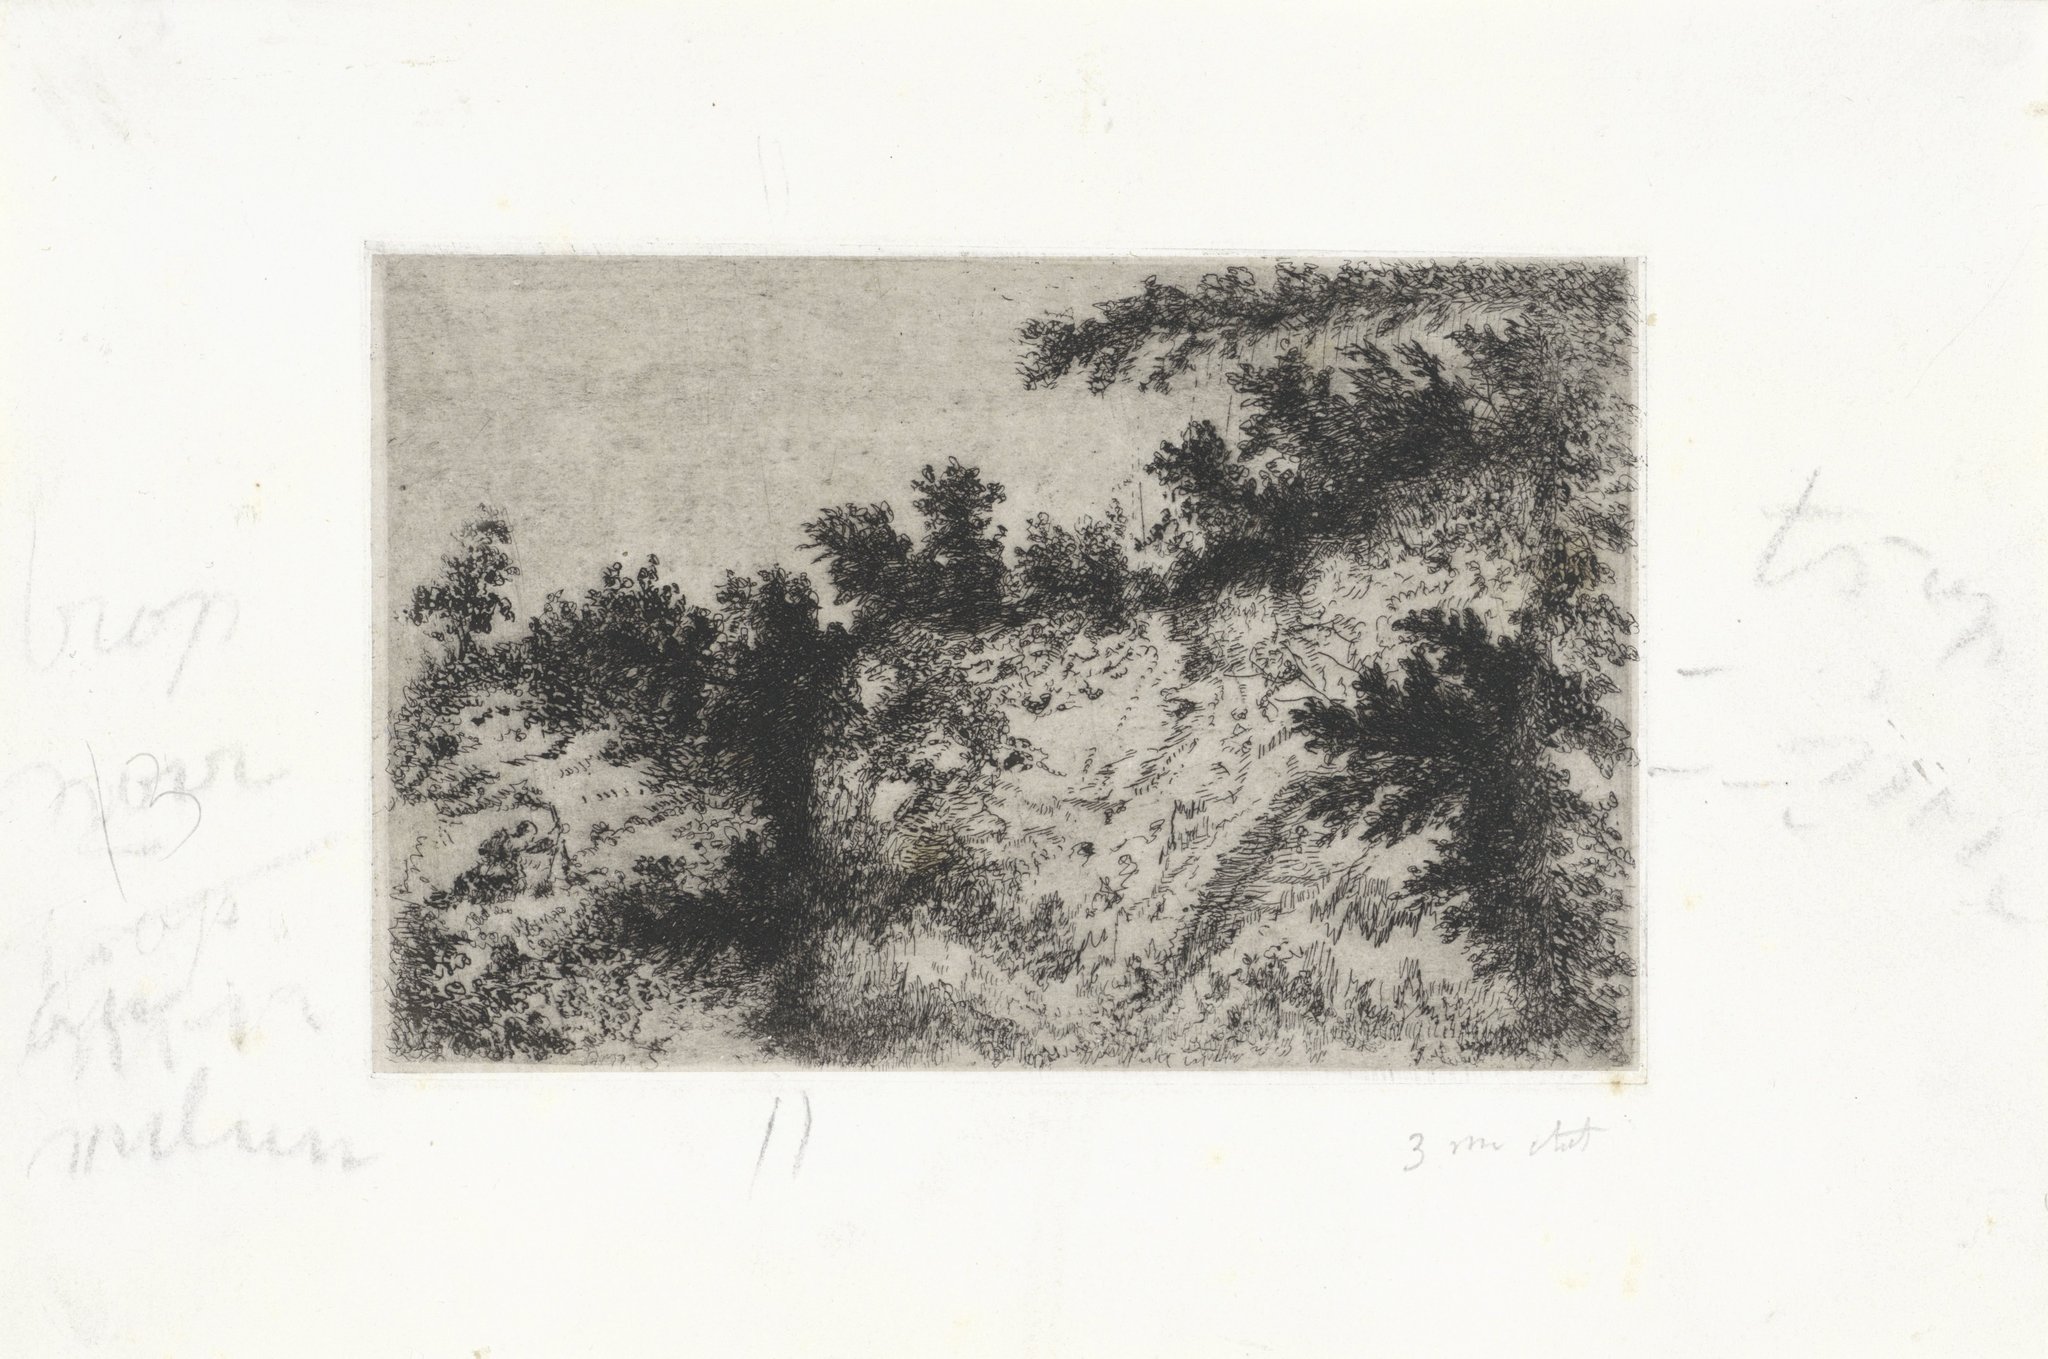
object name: print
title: Rotspunt begroeid met struiken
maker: arnoud schaepkens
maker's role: print maker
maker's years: 1816-1904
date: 1831-1904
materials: paper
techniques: etching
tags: rock-formations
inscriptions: collector's mark: Lugt 2228